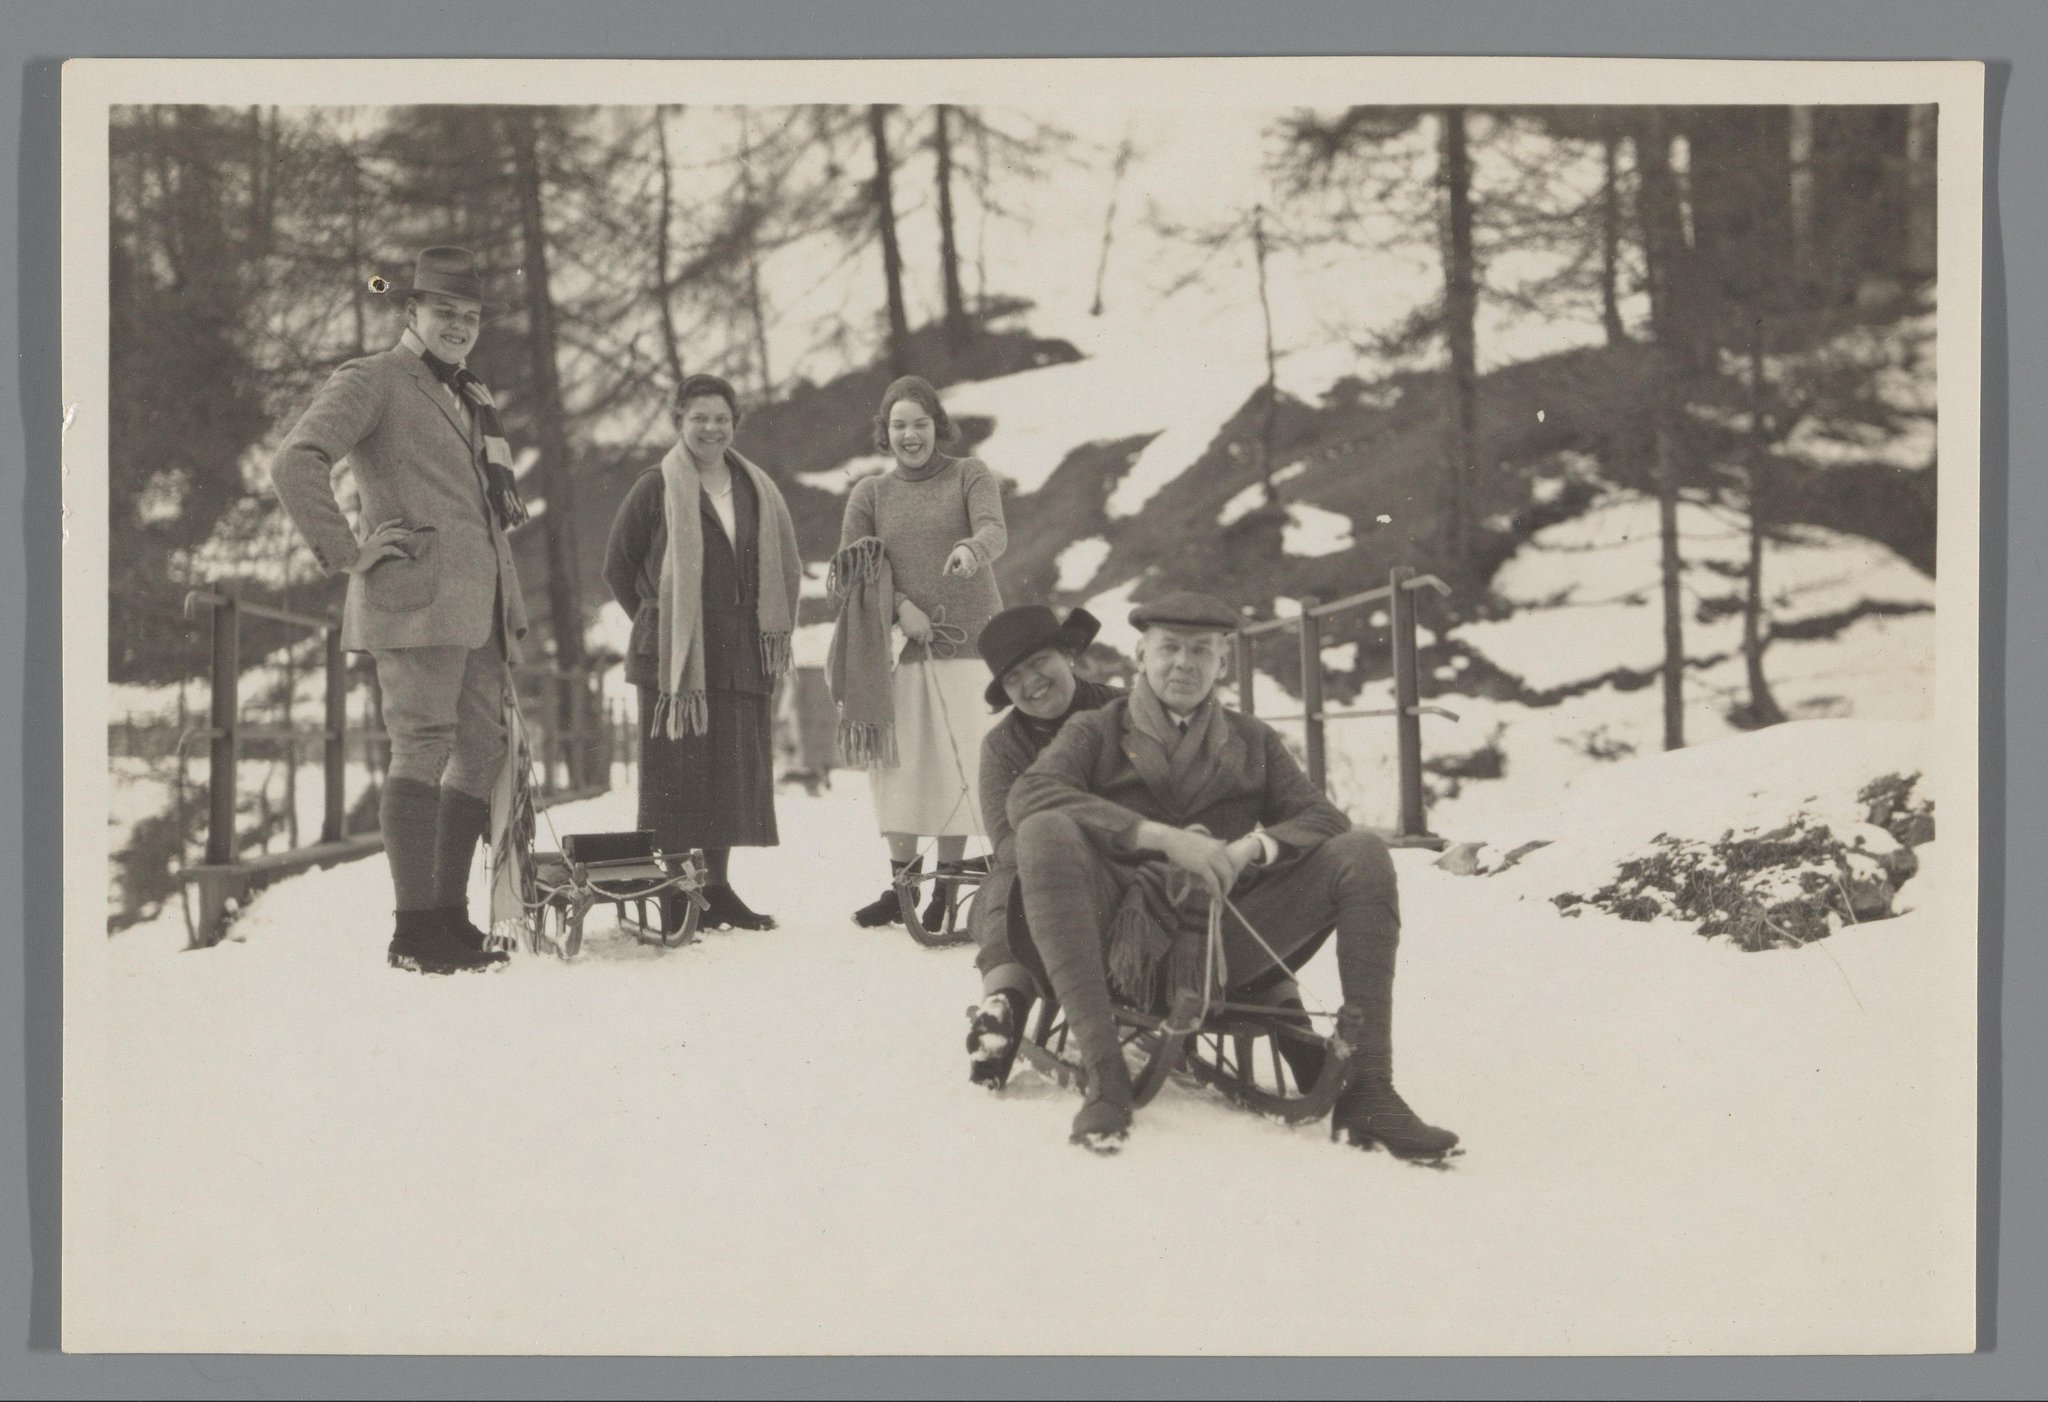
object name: photograph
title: Gezelschap met Karel Frederik van den Berg met sleeën in de sneeuw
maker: Anonymous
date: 1900-1930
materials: photographic support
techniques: photography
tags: batavia, karel frederik van den berg